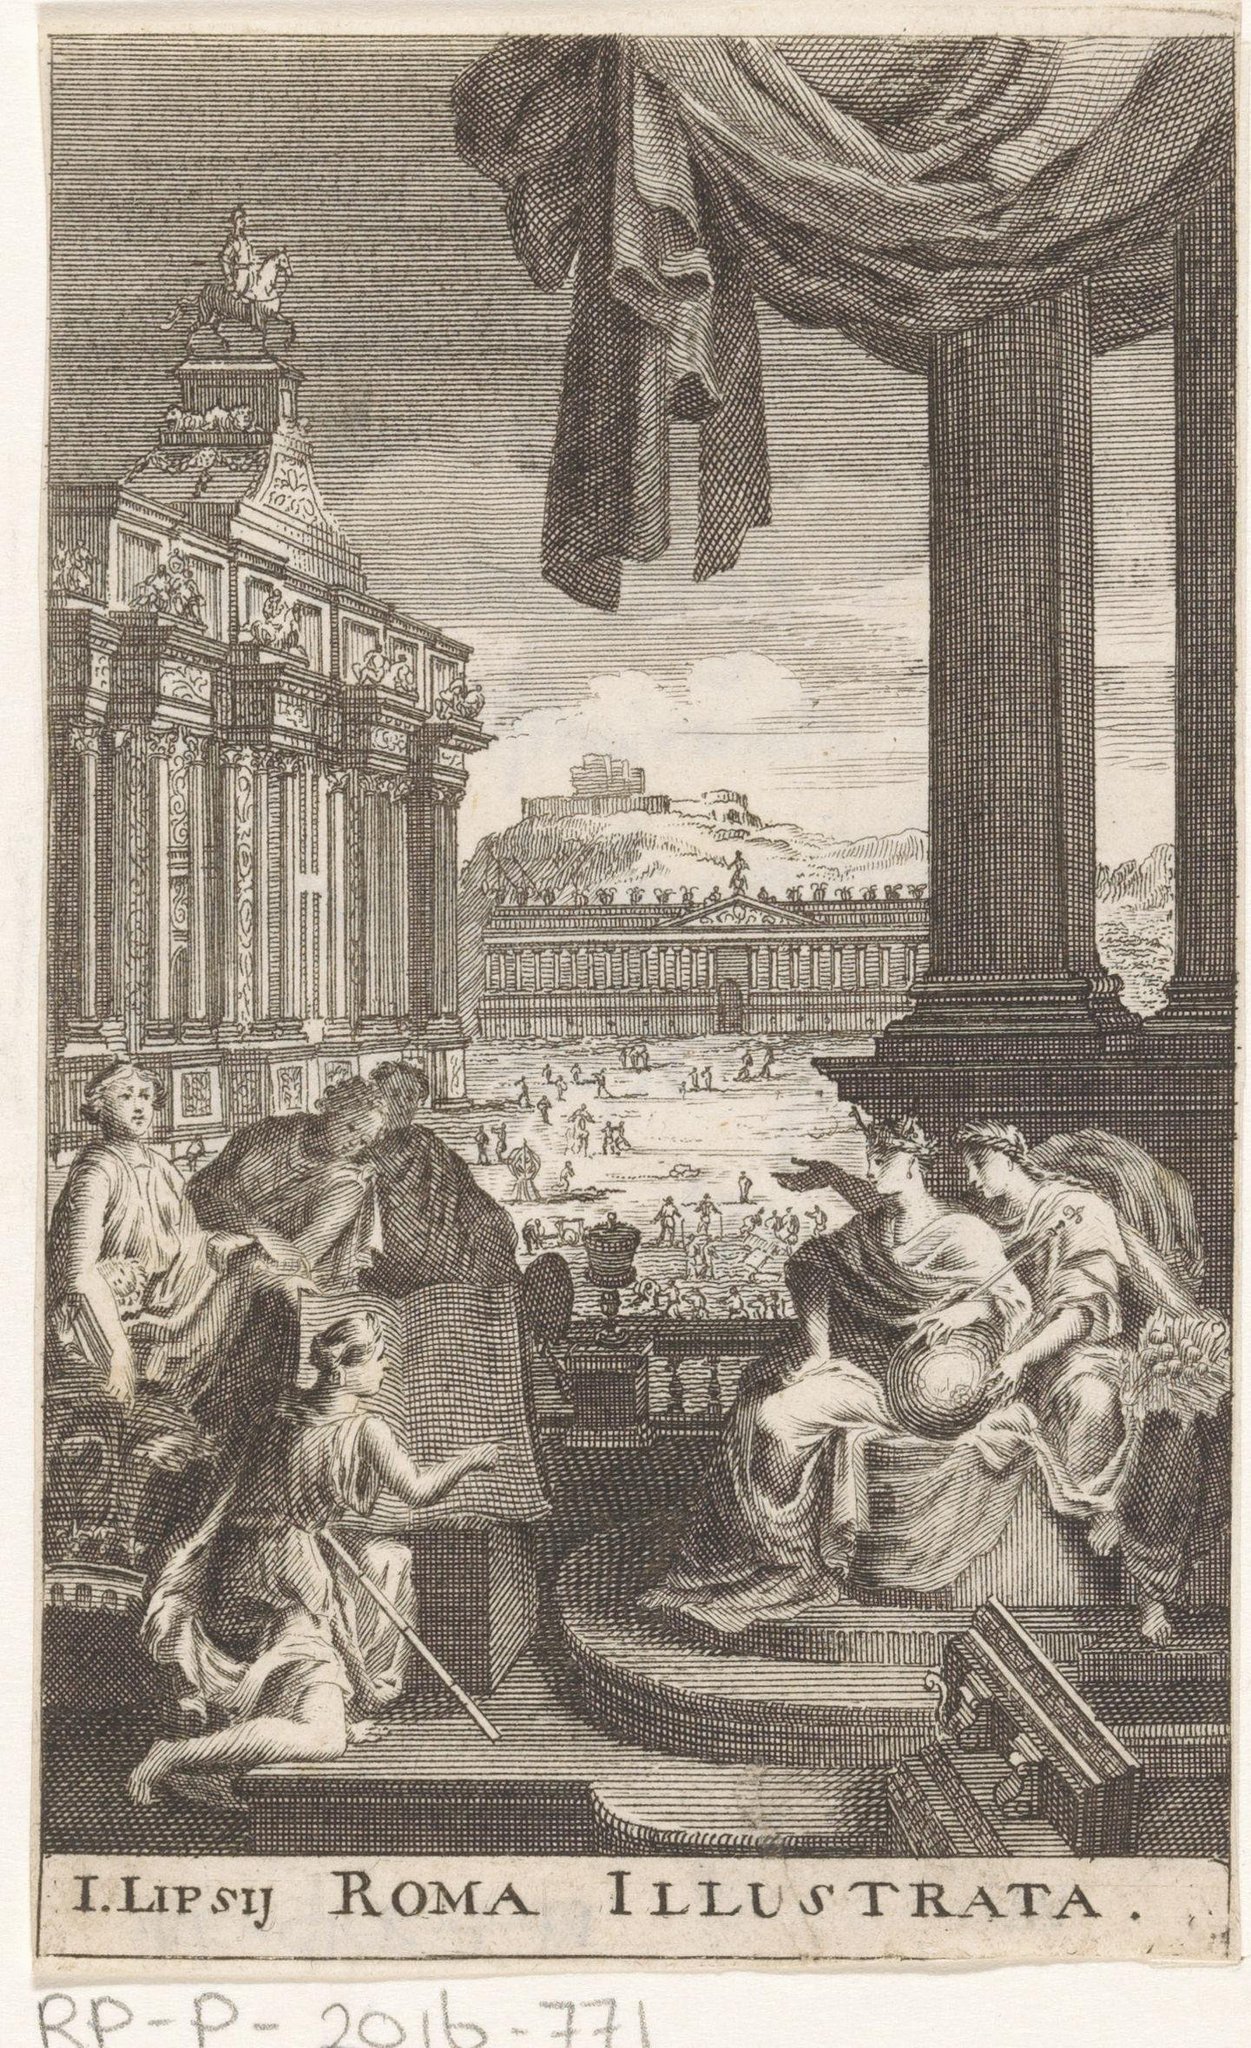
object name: print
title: Kunsten presenteren boek aan gekroonde vrouw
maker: Anonymous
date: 1692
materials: paper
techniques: engraving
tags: crown (symbol of sovereignty), book - mm - book open, symbolic representations, allegories and emblems ~ art; 'arte' (ripa)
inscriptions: collector's mark: Lugt 2228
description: Vier vrouwelijke personificaties van de kunsten met een kapiteel, een buste, een schilderspalet en meetinstrumenten presenteren een boek aan een vrouw met kroon en scepter rechts. Achter haar zit een vrouw met een lauwerkrans en hoorn des overvloeds. In de achtergrond de triomfboog op de Place de la Nation en de oostelijke façade van het Louvre te Parijs, beiden ontworpen door Claude Perrault. De prent is een kopie naar de titelpagina voor Les dix livres d'architecture de Vitruve (1673) van Perrault.